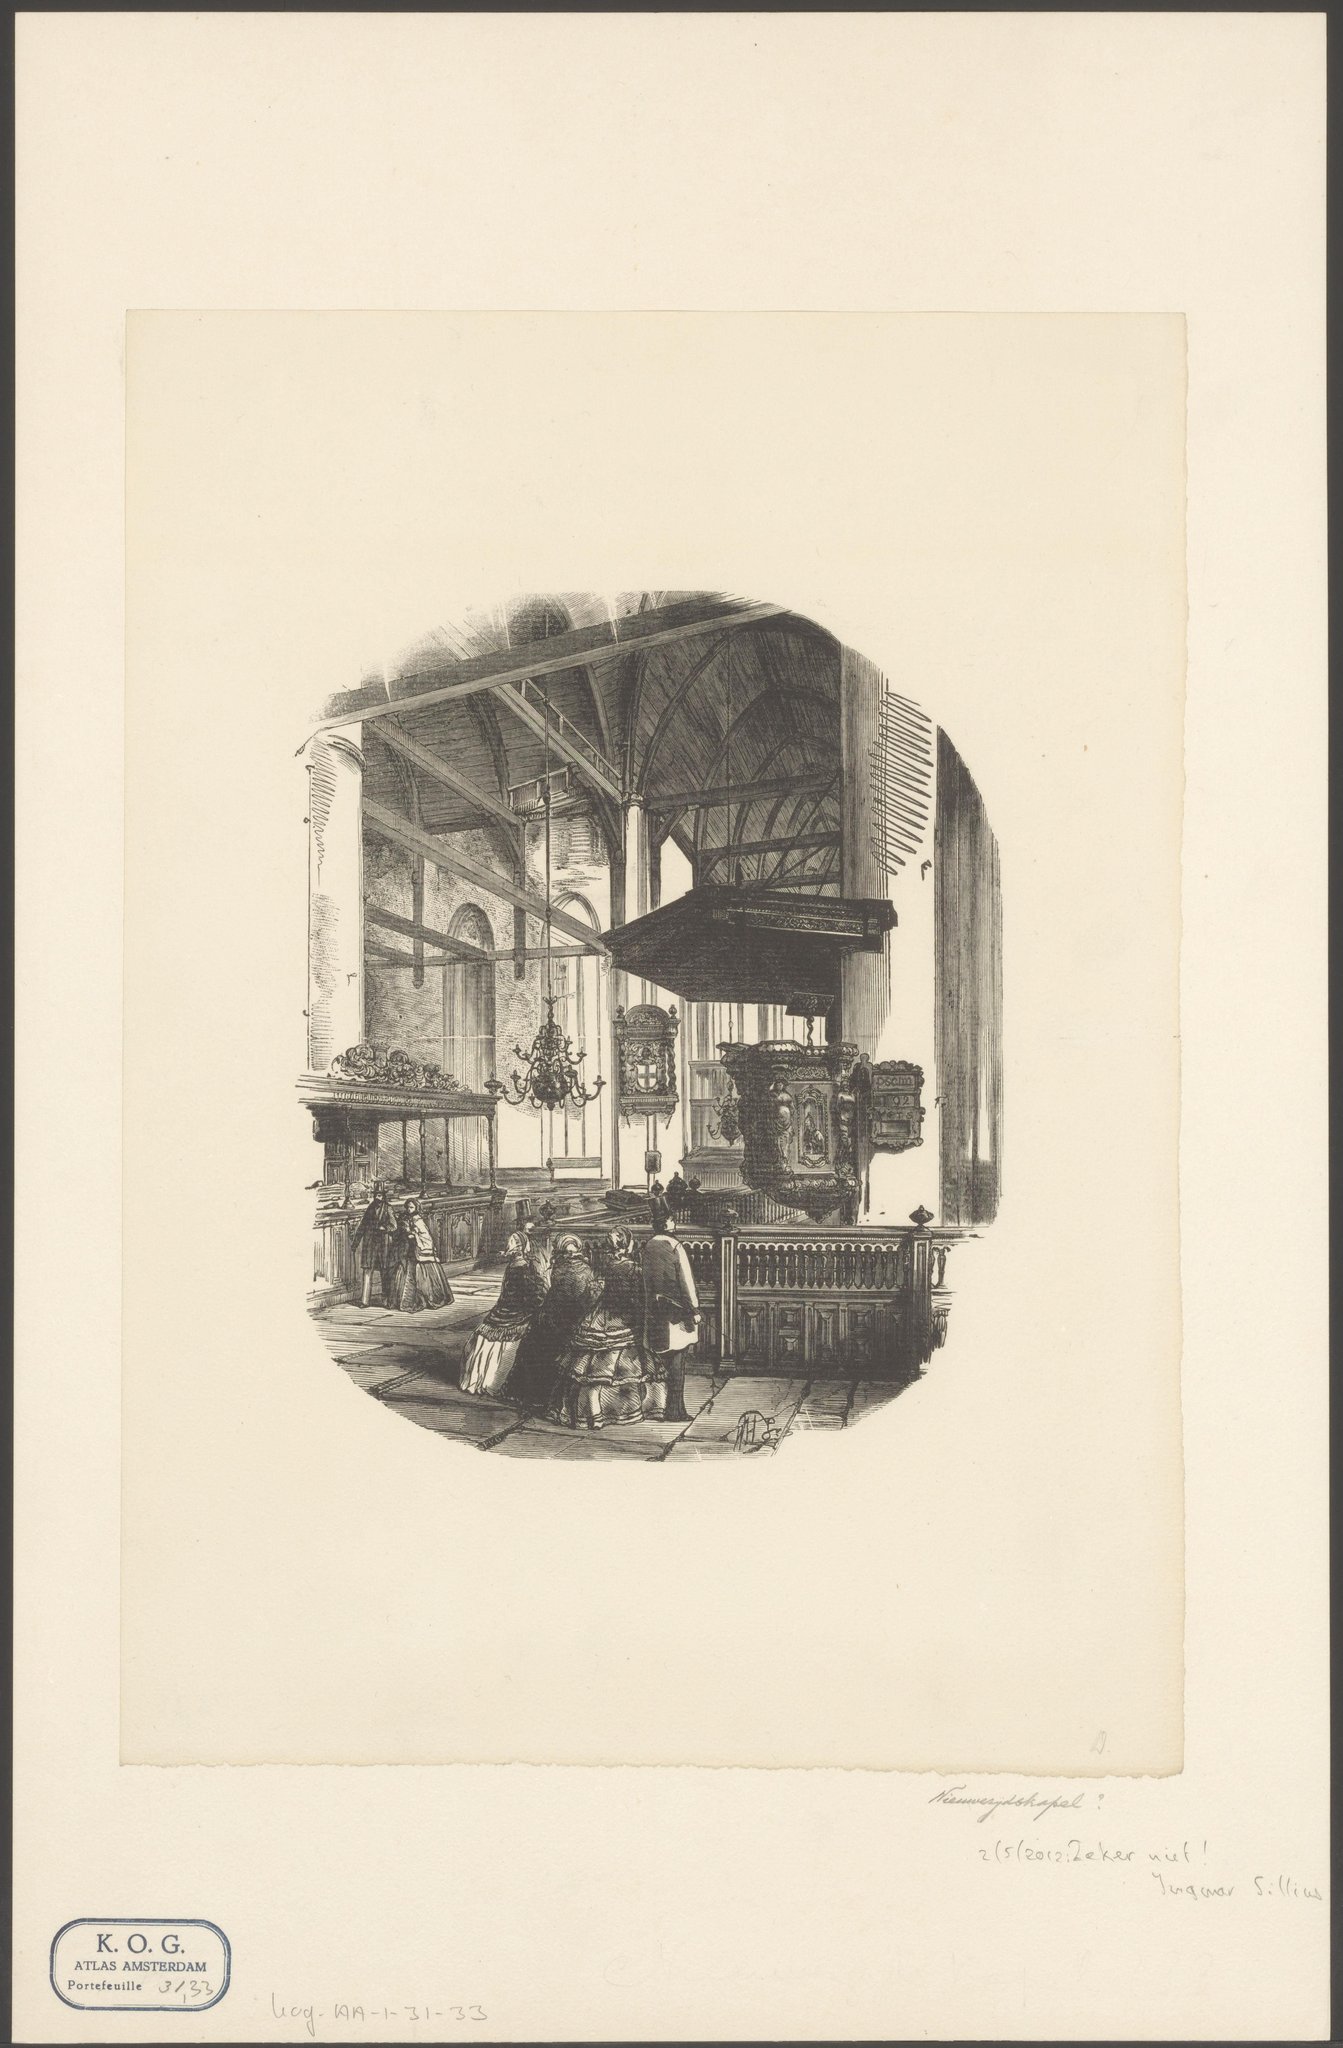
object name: print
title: Interieur van de Grote Kerk te Workum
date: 1835-1888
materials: paper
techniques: engraving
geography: netherlands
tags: interior of church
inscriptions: collector's mark: Lugt 1641b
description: Onderwerpsrubriek binnen de Atlas Amsterdam: Kerkwezen: Hervormde Gemeente: Nieuwezijds Kapel.